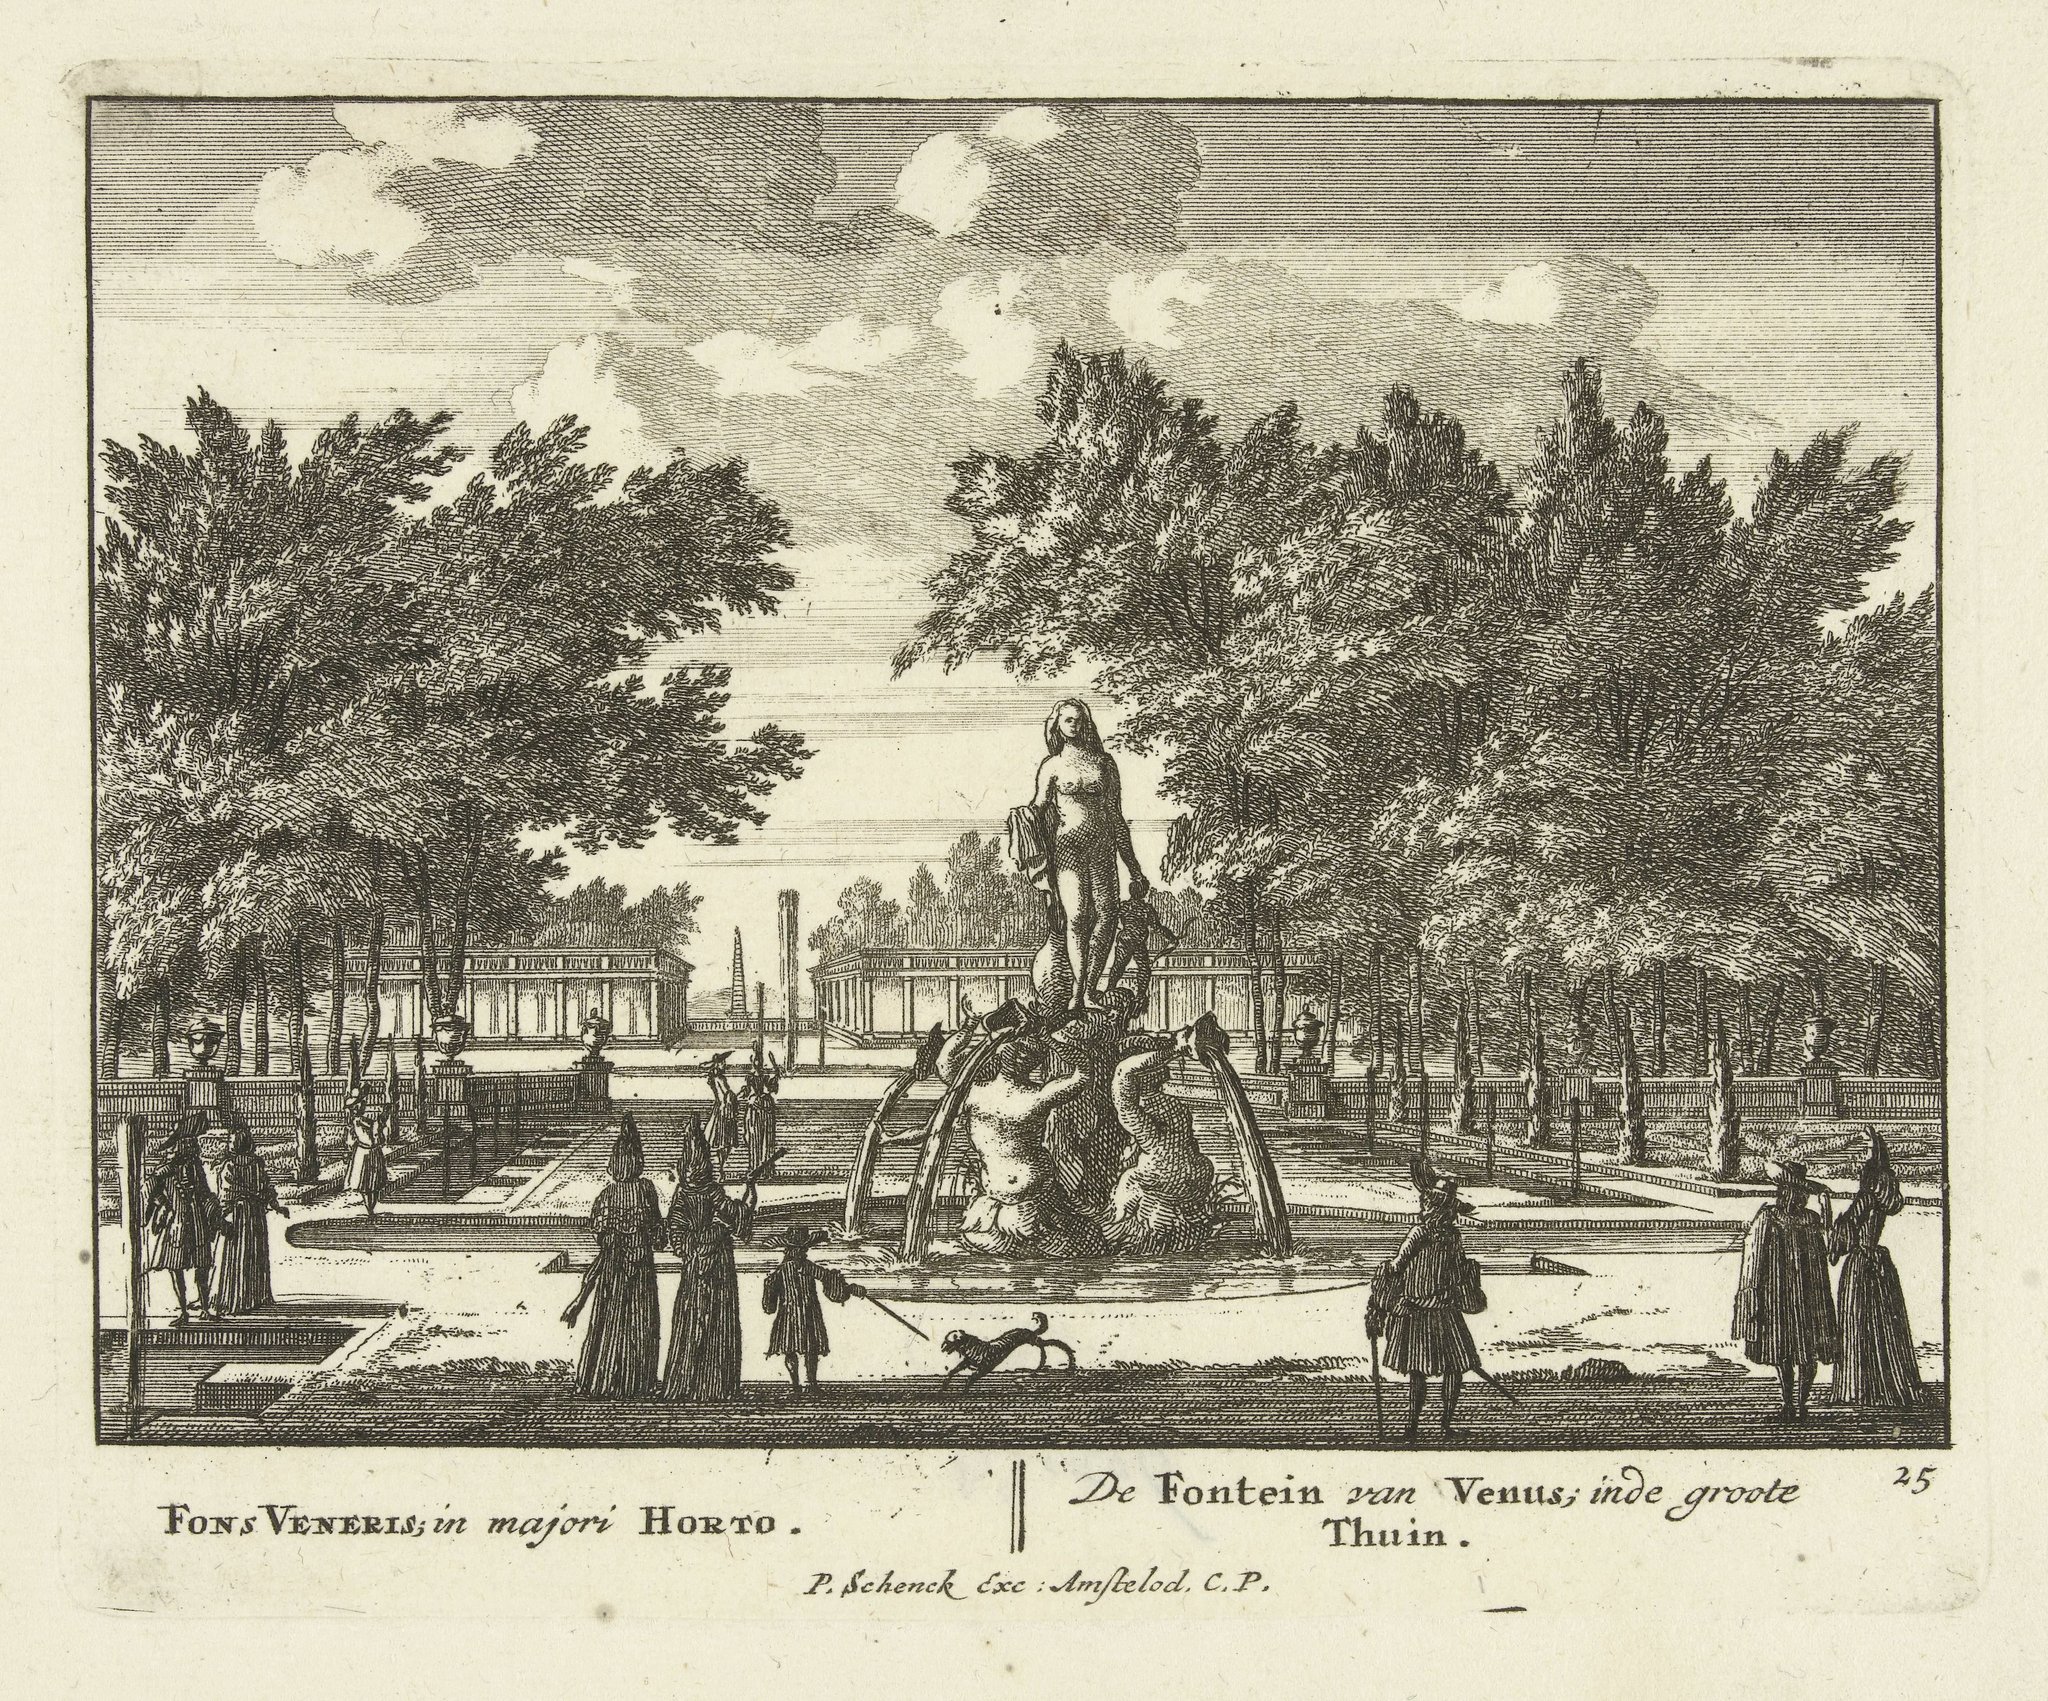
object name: print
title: Uitgeleesene Gesichte van het Wijdvermaarde Loo als andere vorstelijke Huisen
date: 1695-1705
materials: paper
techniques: etching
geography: amsterdam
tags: garden fountain, french or architectonic garden; formal garden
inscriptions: collector's mark: Lugt 2228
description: Elegant geklede dames en heren kijken naar de Venus-fontein in de tuinen van Het Loo. Op de achtergrond zijn de collonnades en de obelisk zichtbaar. Prent uit een serie van 71 prenten met Rijnlandschappen, gezichten op vorstelijke paleizen en stadsgezichten uit Den Haag en Amsterdam.